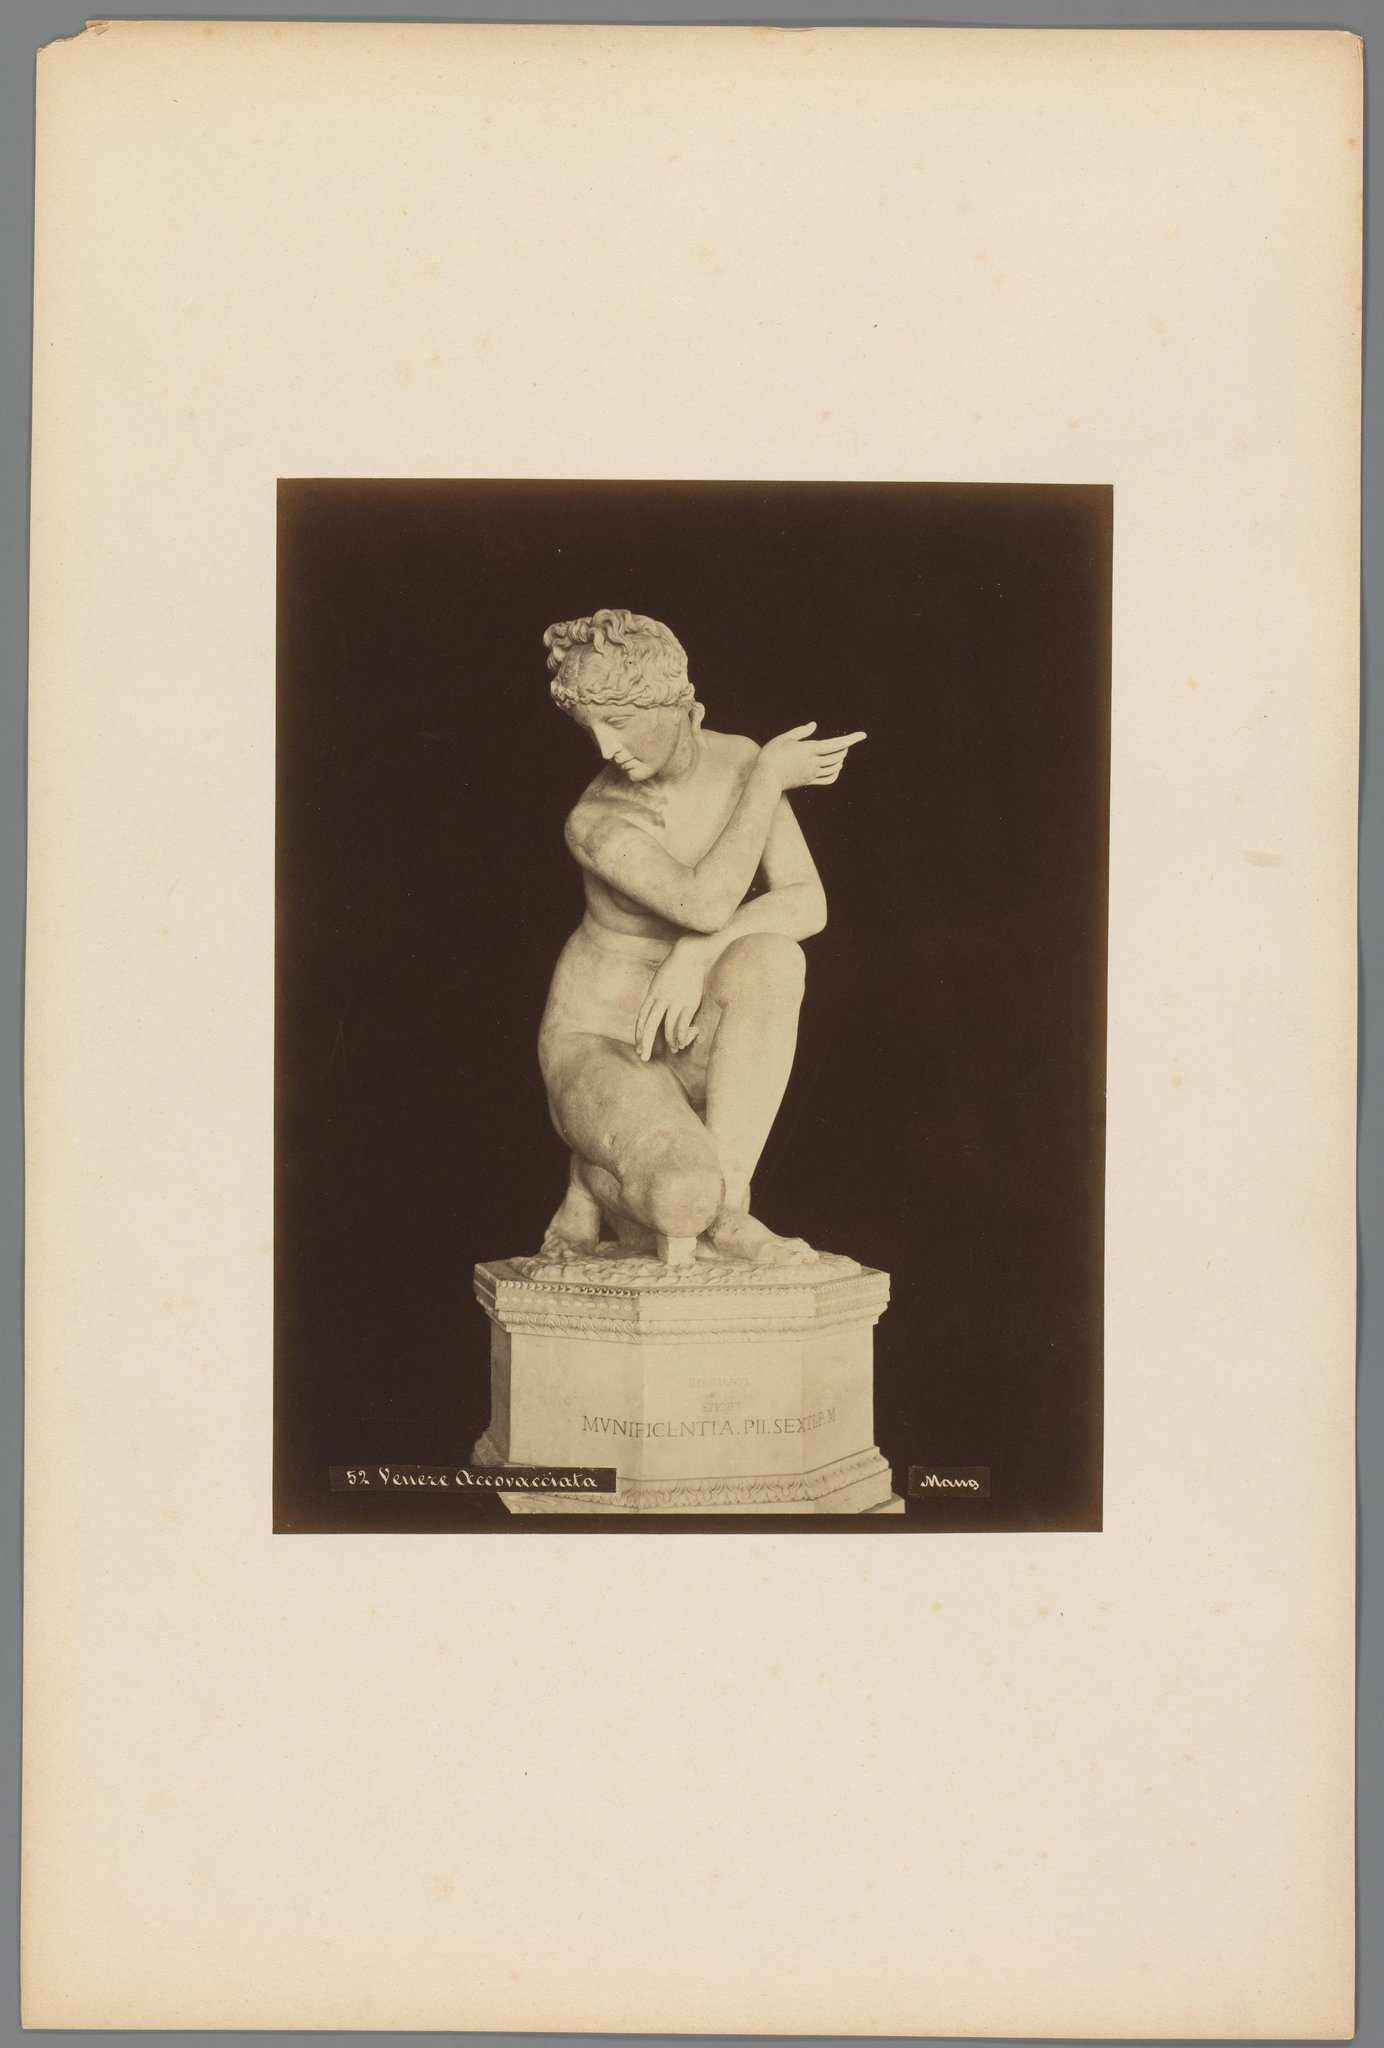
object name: photograph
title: Venere. Accovacciata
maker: michèle mang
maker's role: fotograaf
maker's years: 1840-1909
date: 1863-1887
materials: cardboard, paper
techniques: albumen print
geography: vatican city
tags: bath of venus, piece of sculpture, reproduction of a piece of sculpture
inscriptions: number: ‘52.’